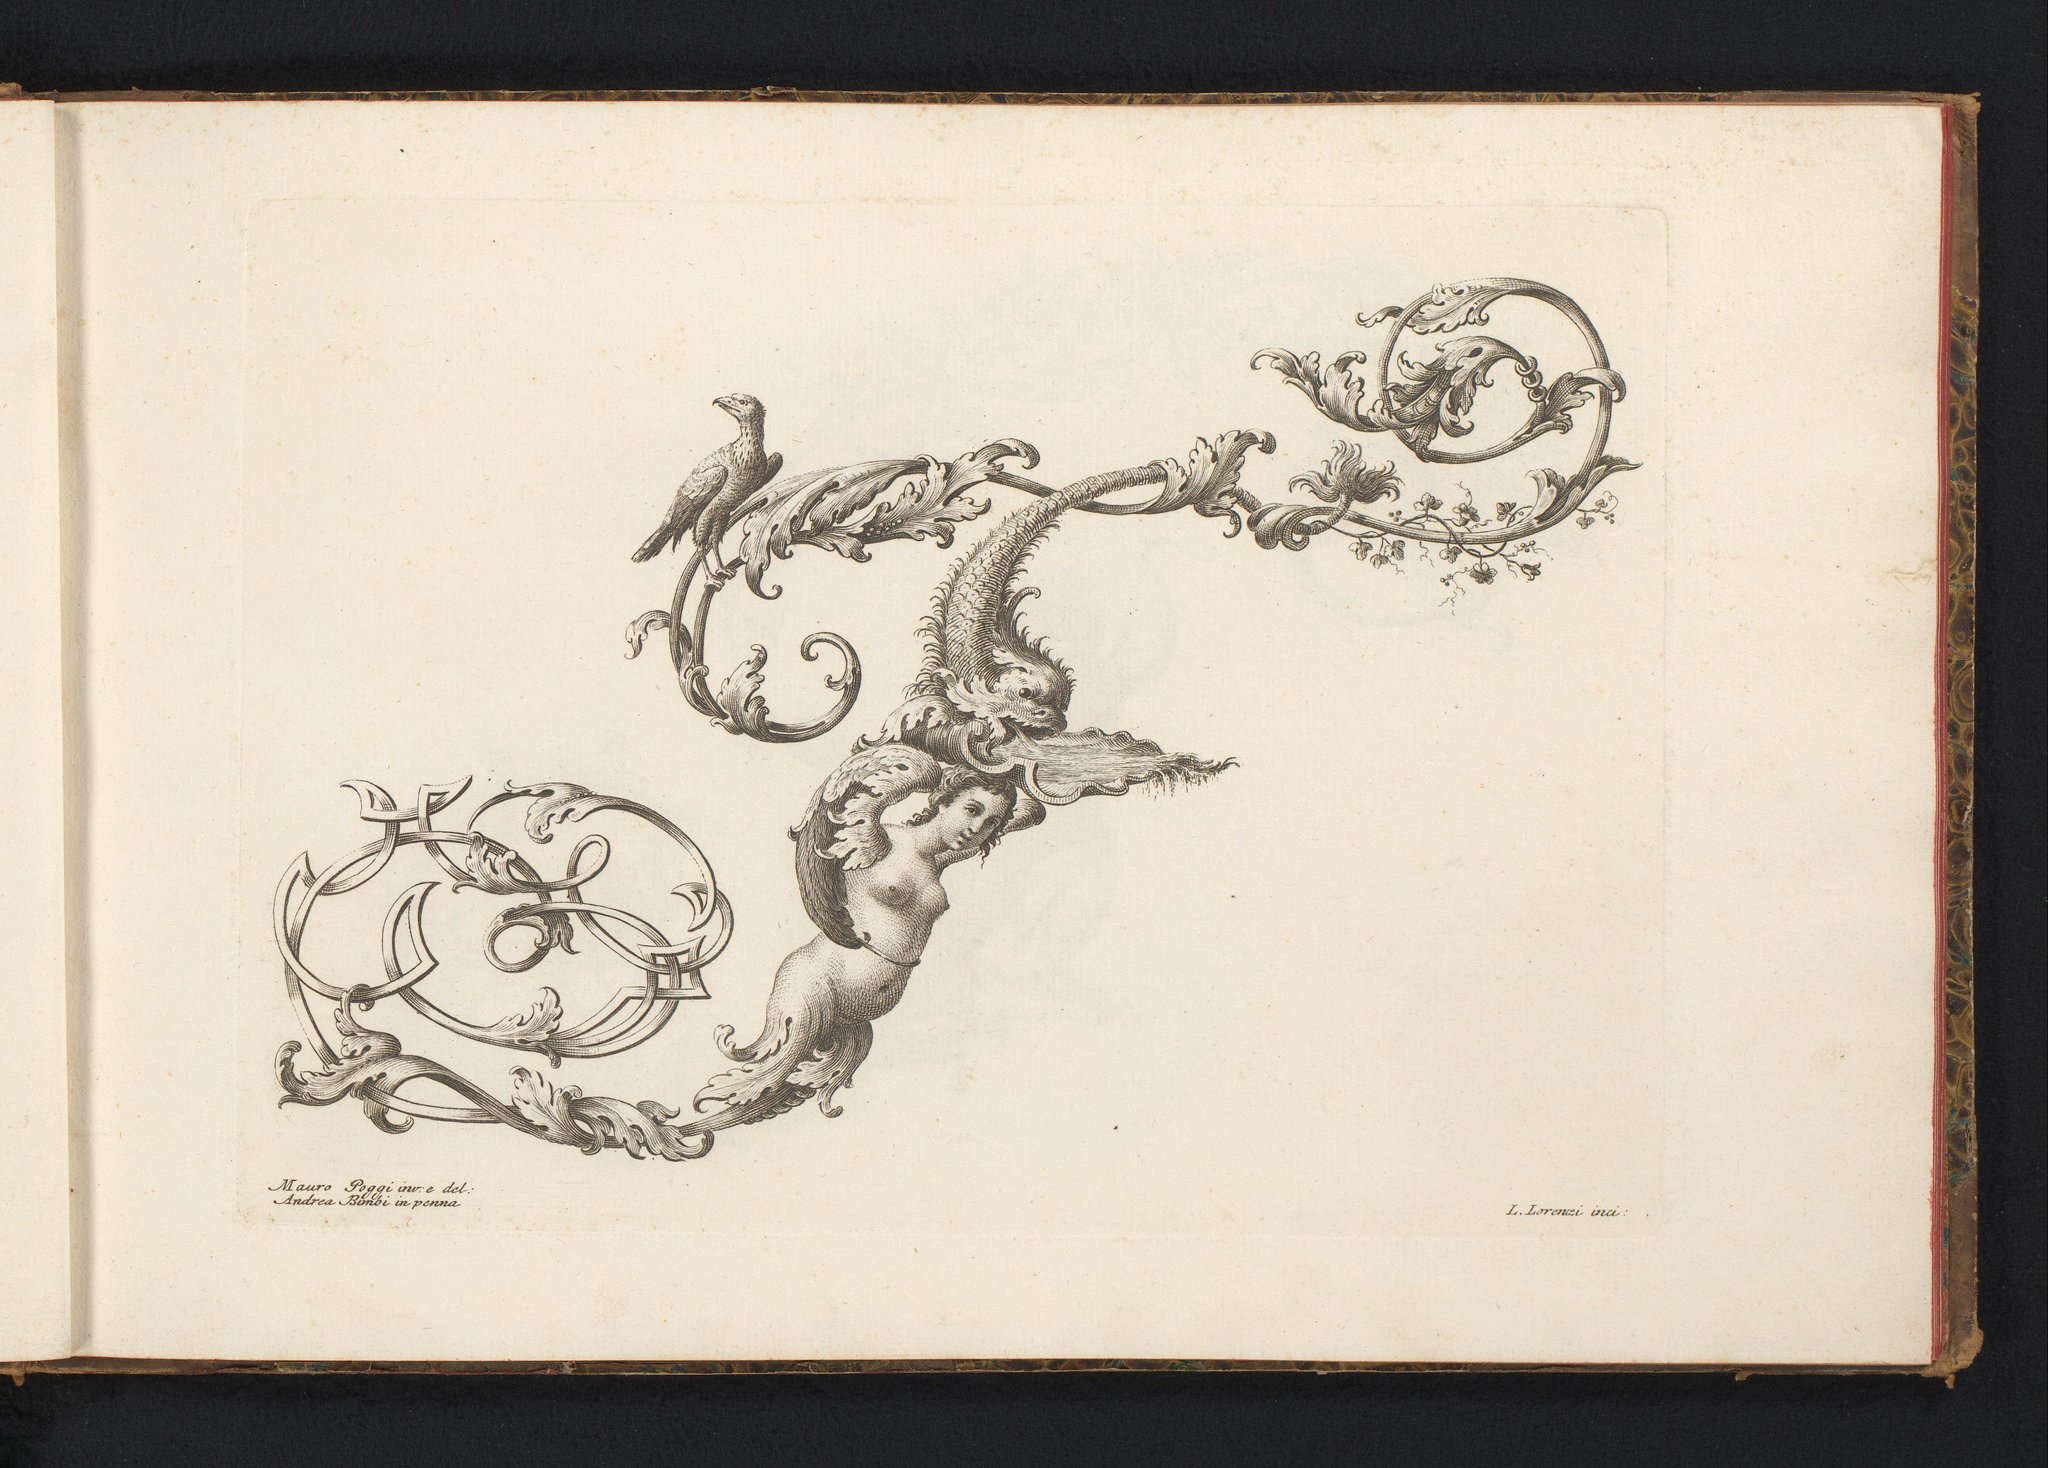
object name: print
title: Ornamentele letter F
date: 1745-1765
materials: paper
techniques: engraving, etching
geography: italy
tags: letters, alphabet, script, fancy letters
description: Ornamentele letter F, versierd met een vogel, een vis en een gevleugelde vrouwenfiguur. Prent maakt deel uit van een album.